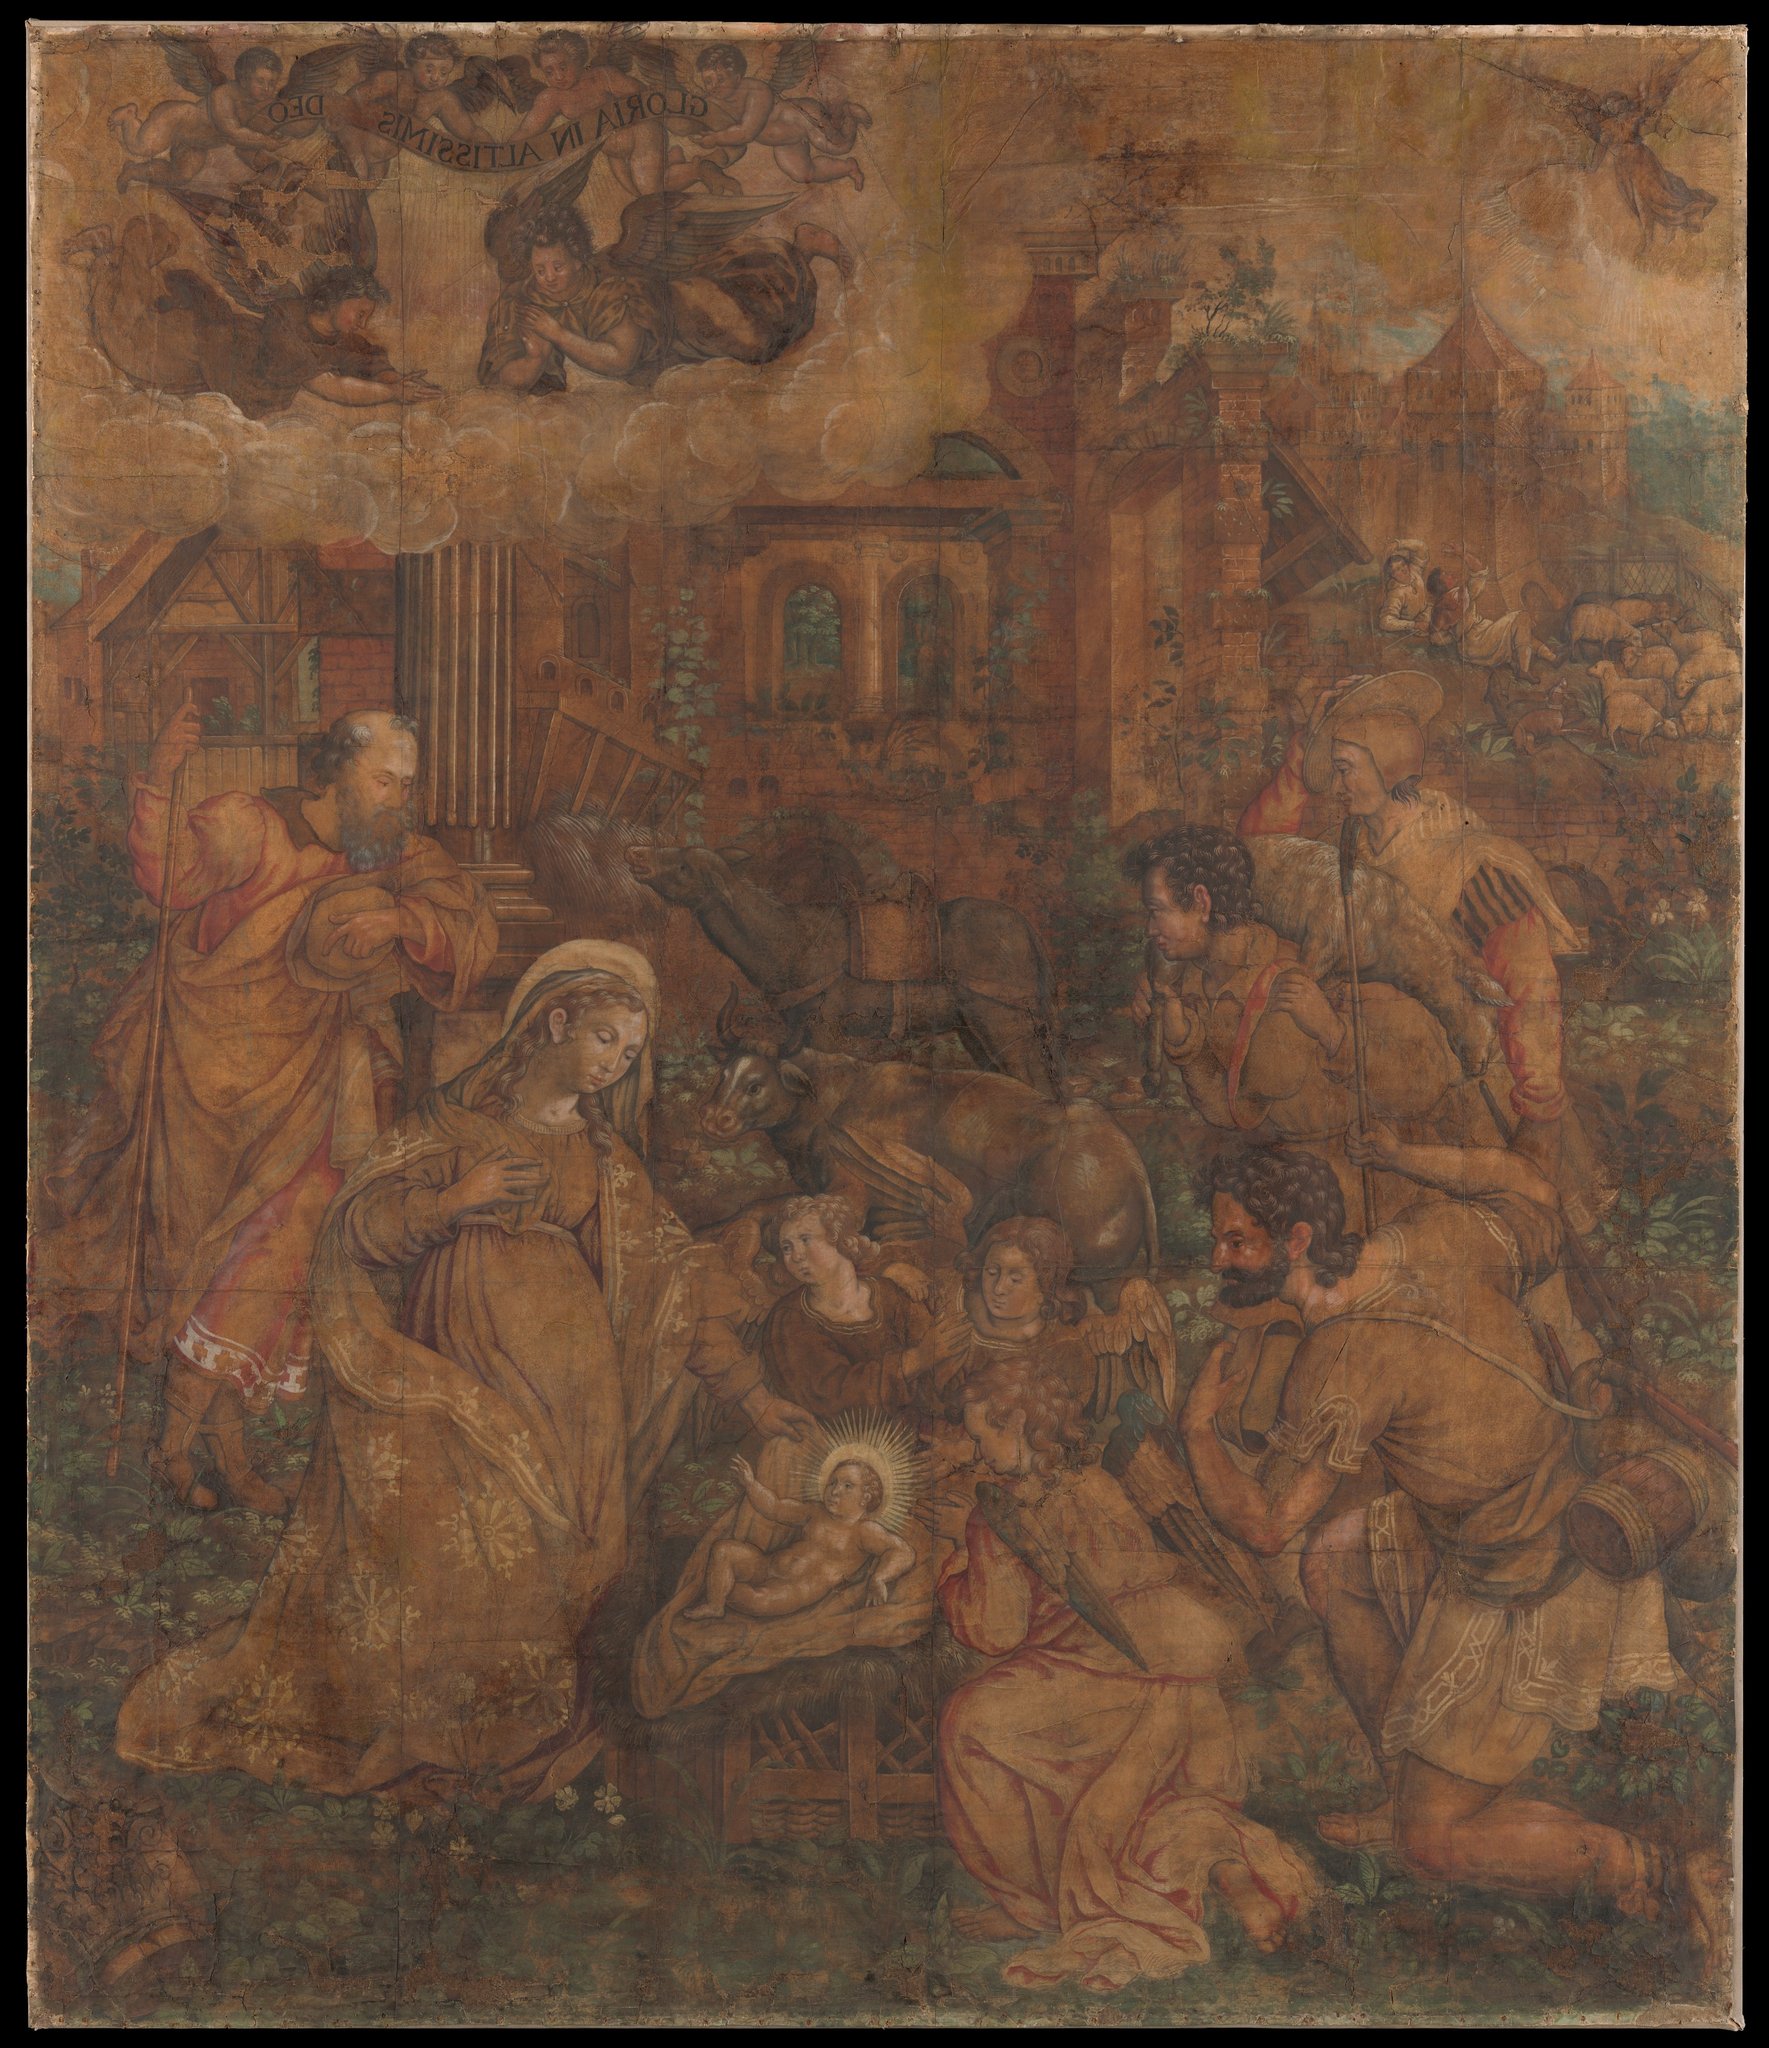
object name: drawing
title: The Adoration of the Shepherds (Cartoon)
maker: anonymous, netherlandish, 16th century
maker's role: artist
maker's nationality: netherlandish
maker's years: 1500-1600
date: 1501-1600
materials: paint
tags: men,women,angels,adoration of the shepherds